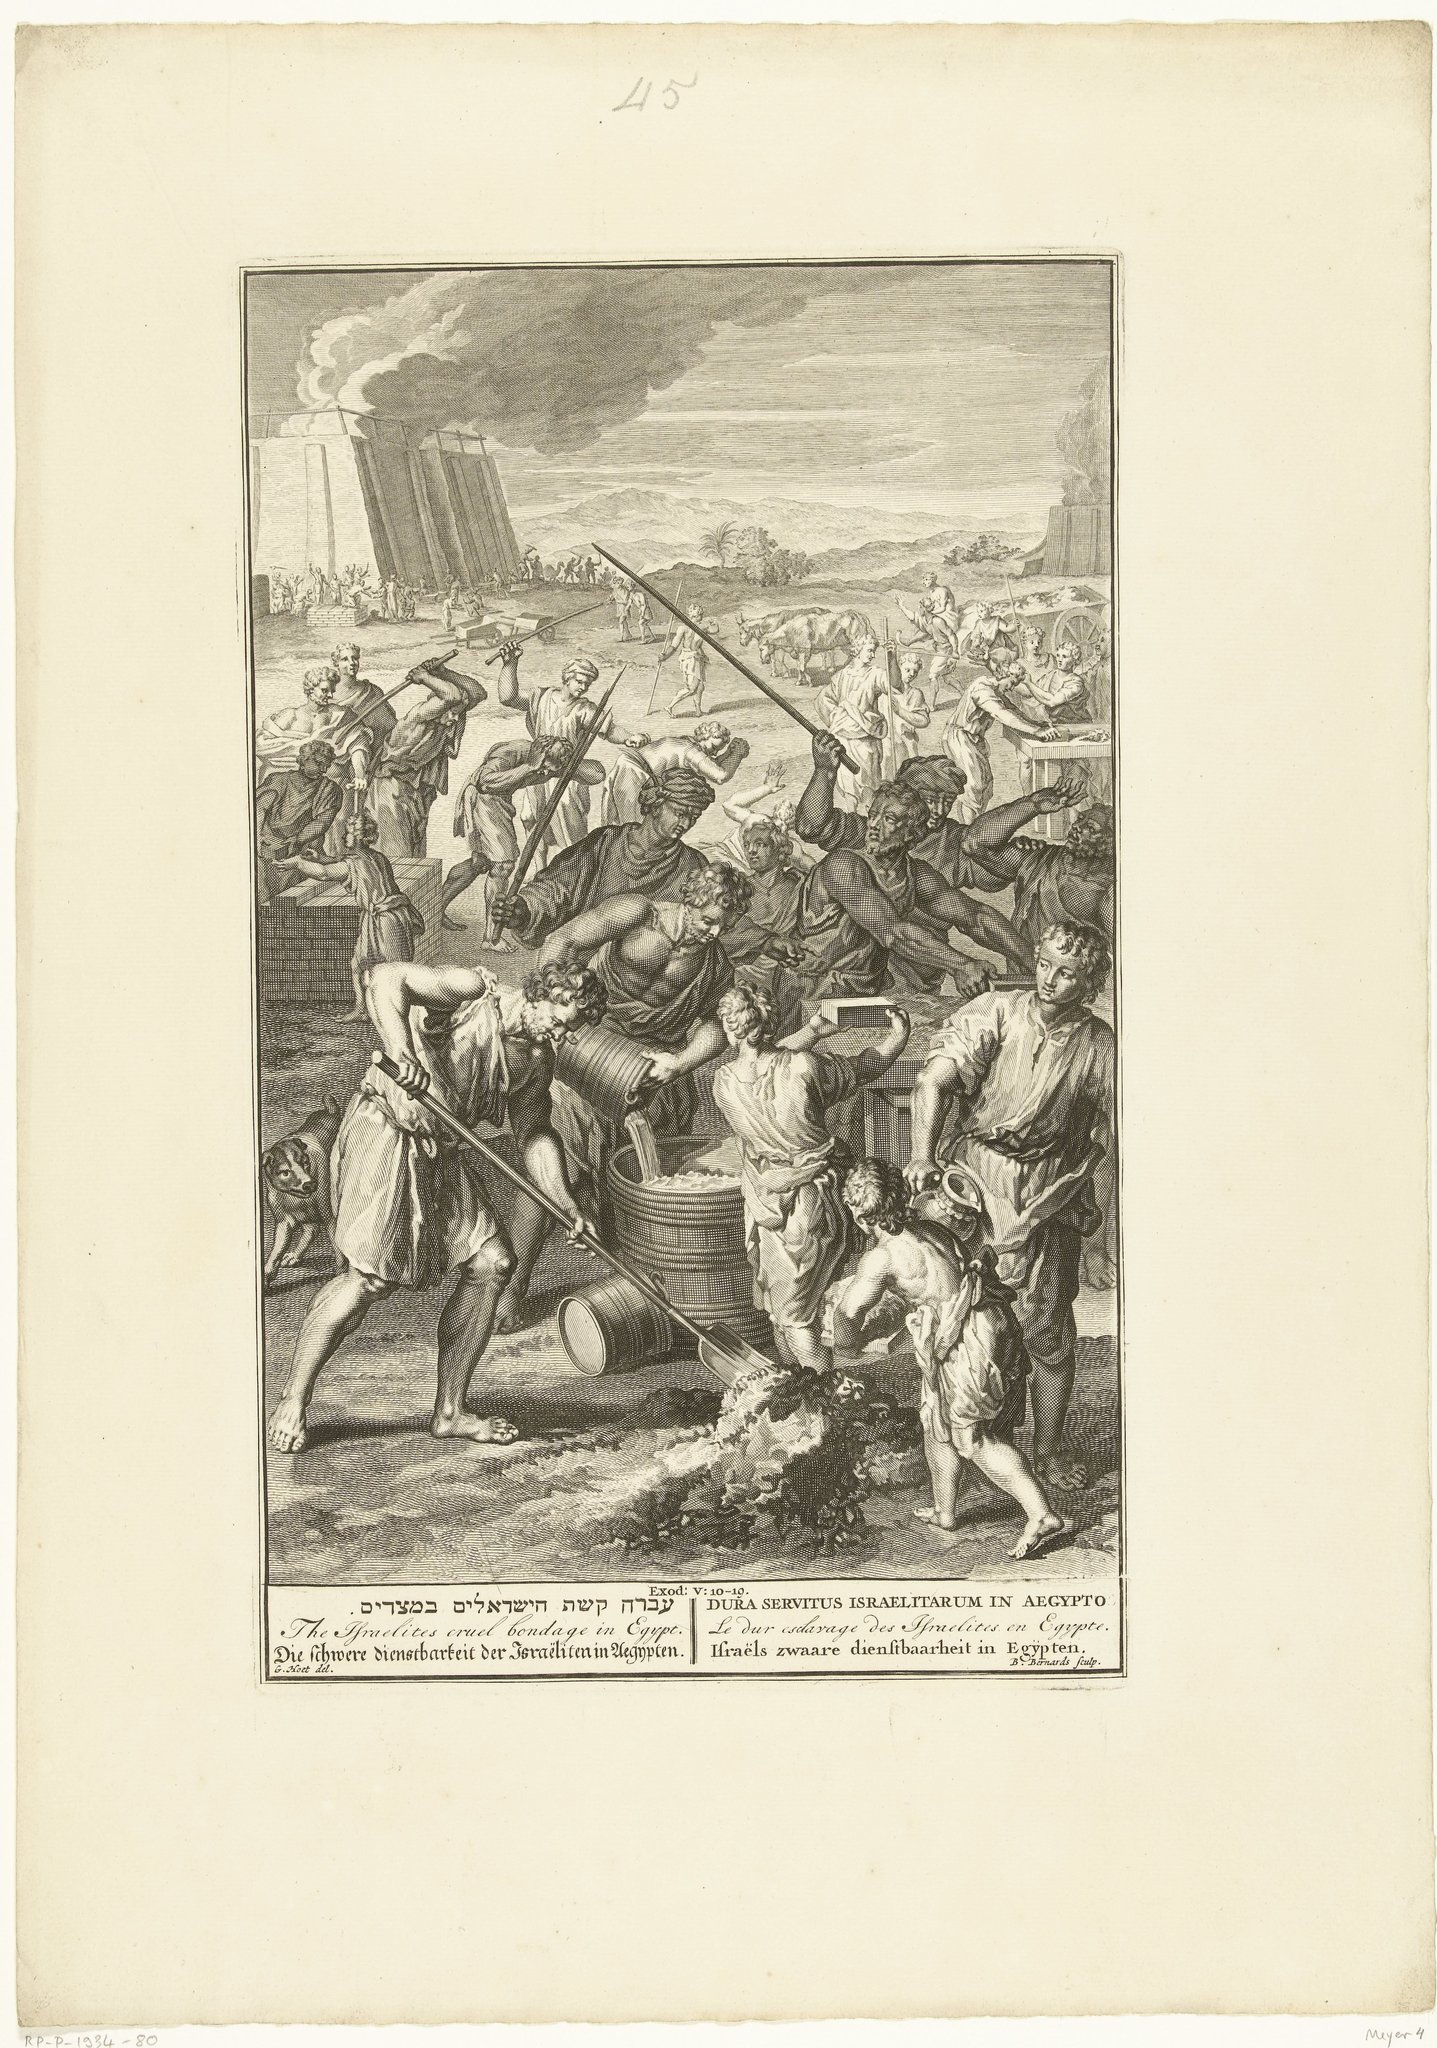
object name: print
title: Israëls zwaare dienstbaarheit in Egÿpten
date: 1720-1728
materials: paper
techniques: engraving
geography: amsterdam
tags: pharaoh commands the taskmasters to stop supplying the people with straw for making bricks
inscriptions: collector's mark: Lugt 2228, inscription: ‘Utrechts Fundatie Huijs’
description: Prent gemaakt voor: Figures de la Bible. Amsterdam, Bernard Picart, 1720. Prent ook gebruikt in: Taferelen der voornaamste geschiedenissen van het Oude en Nieuwe Testament (...) door de vermaarde kunstenaars Hoet, Houbraken, en Picart getekent (...) en met beschrijvingen uitgebreid. Den Haag: Pieter de Hondt, 1728.